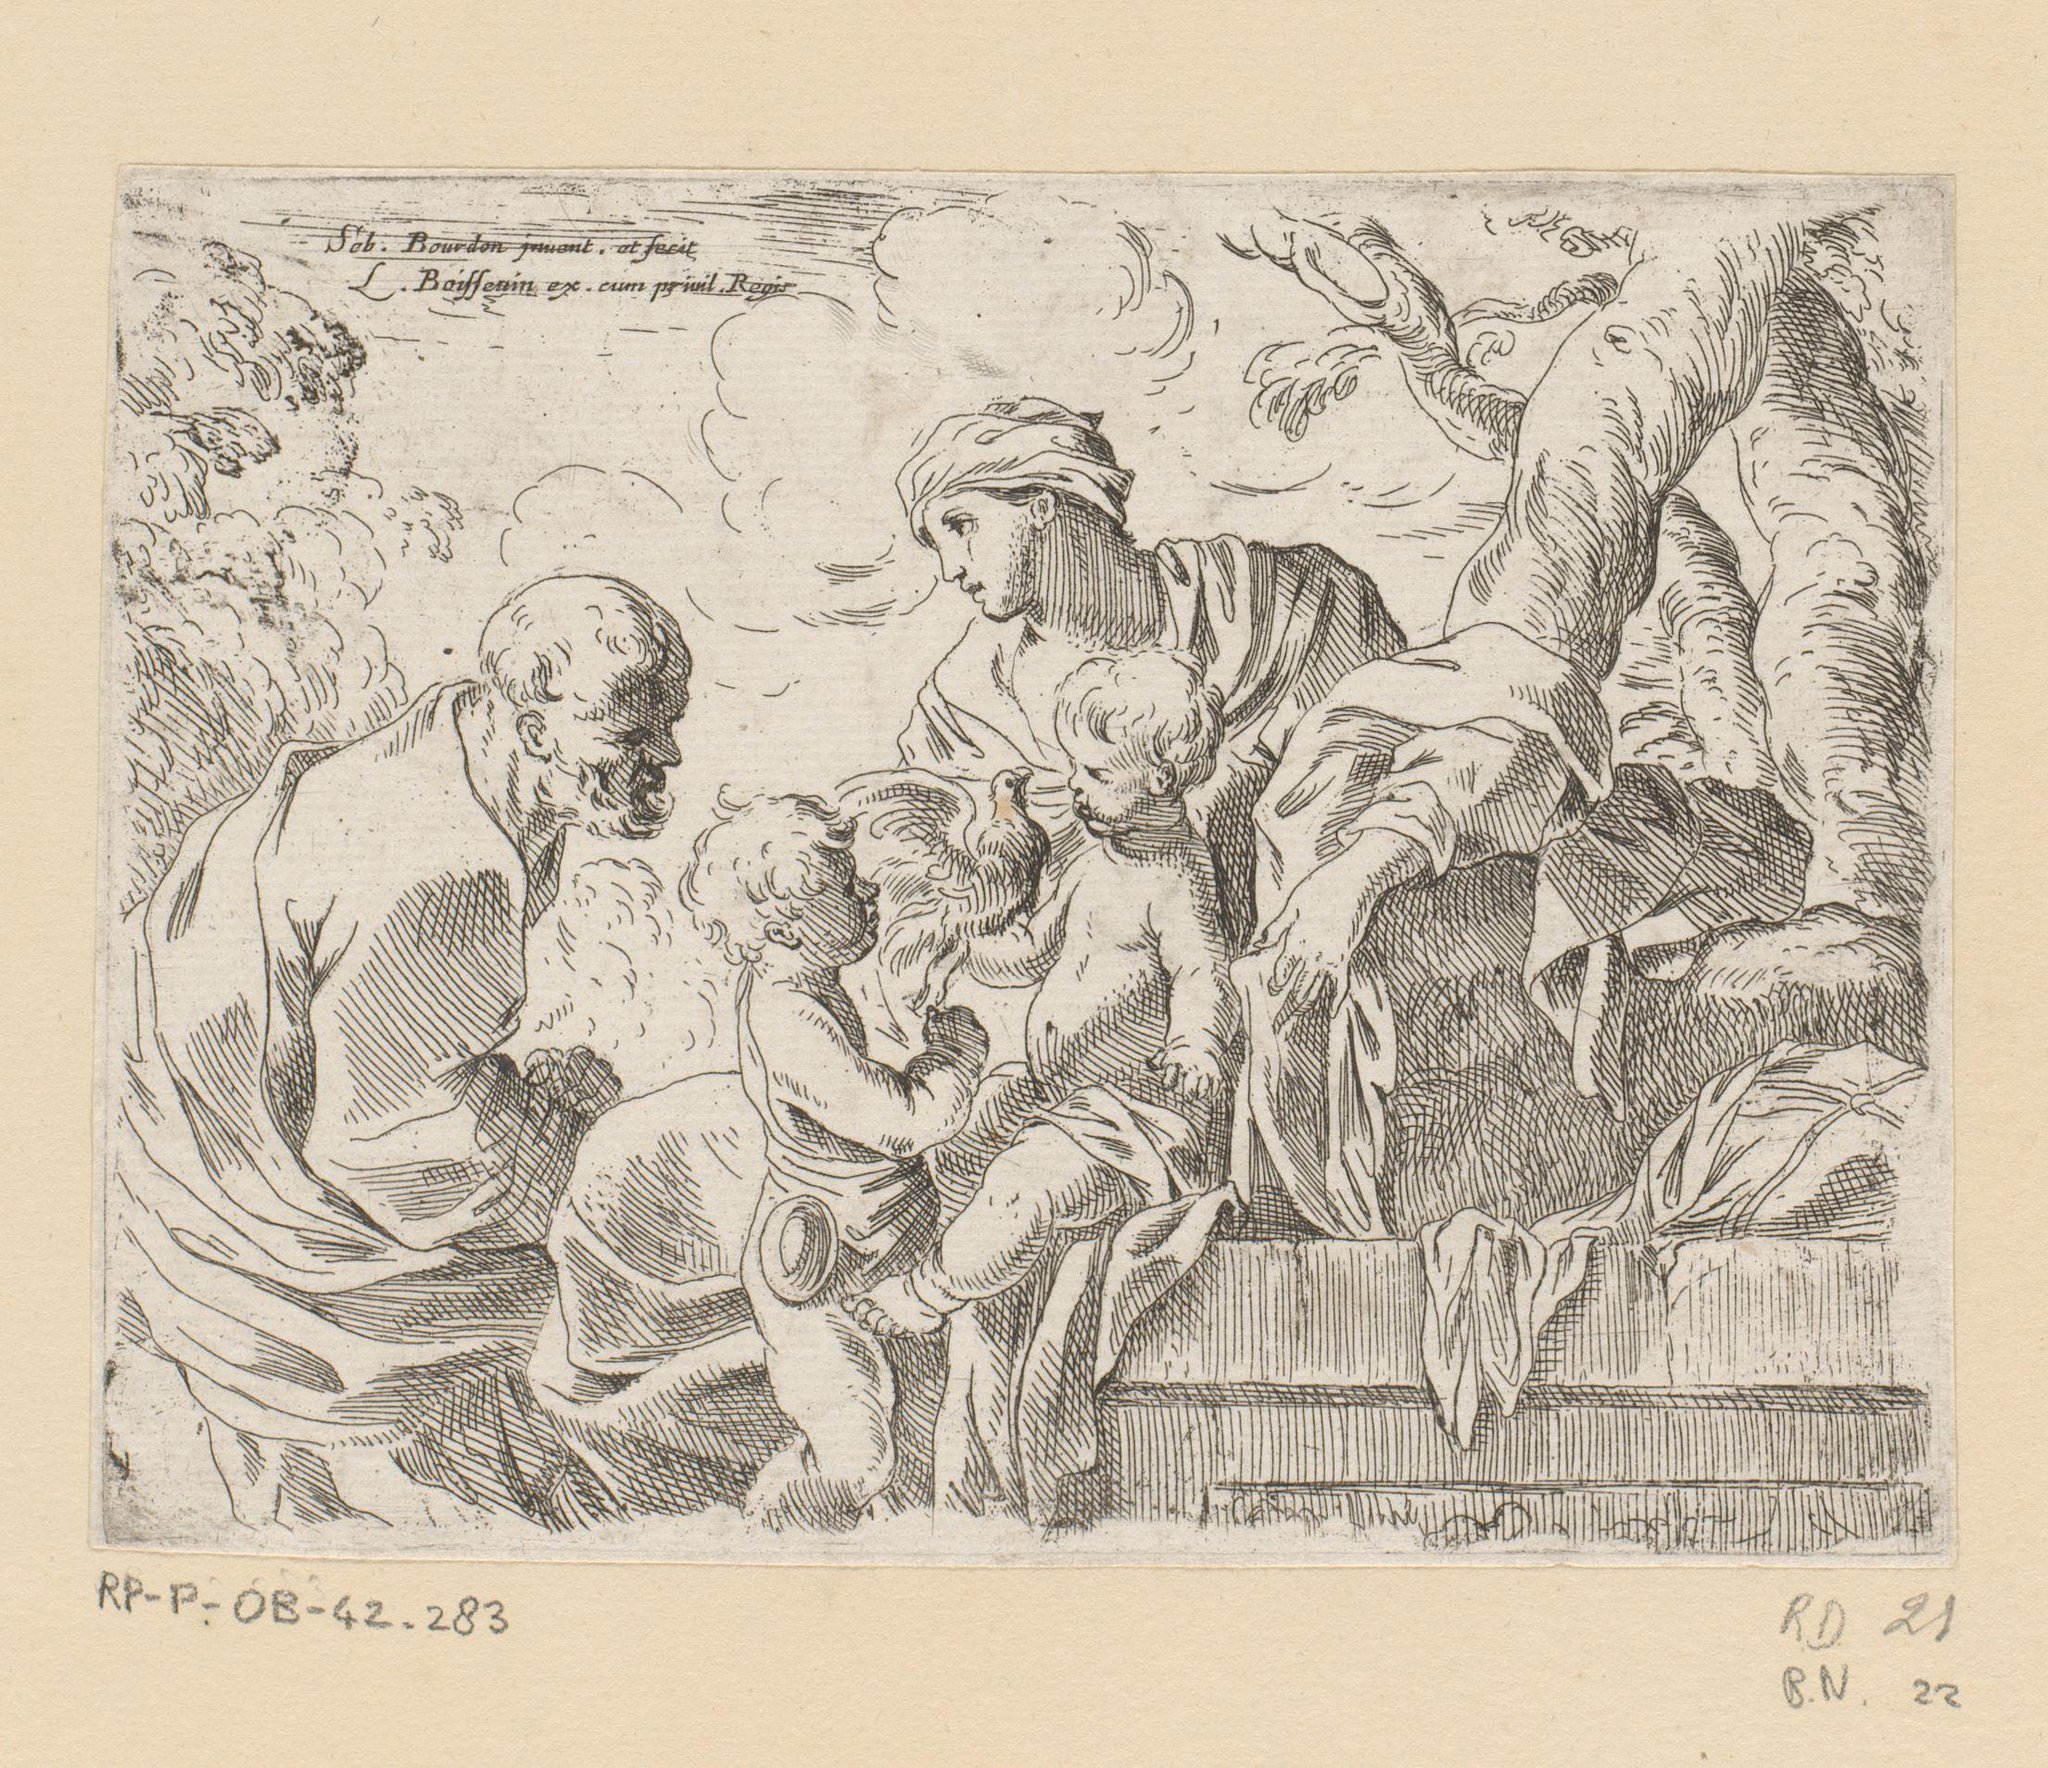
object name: print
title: Heilige Familie met Johannes de Doper en vogel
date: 1626-1671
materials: paper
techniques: etching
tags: holy family with john the baptist (as child)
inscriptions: collector's mark: Lugt 240